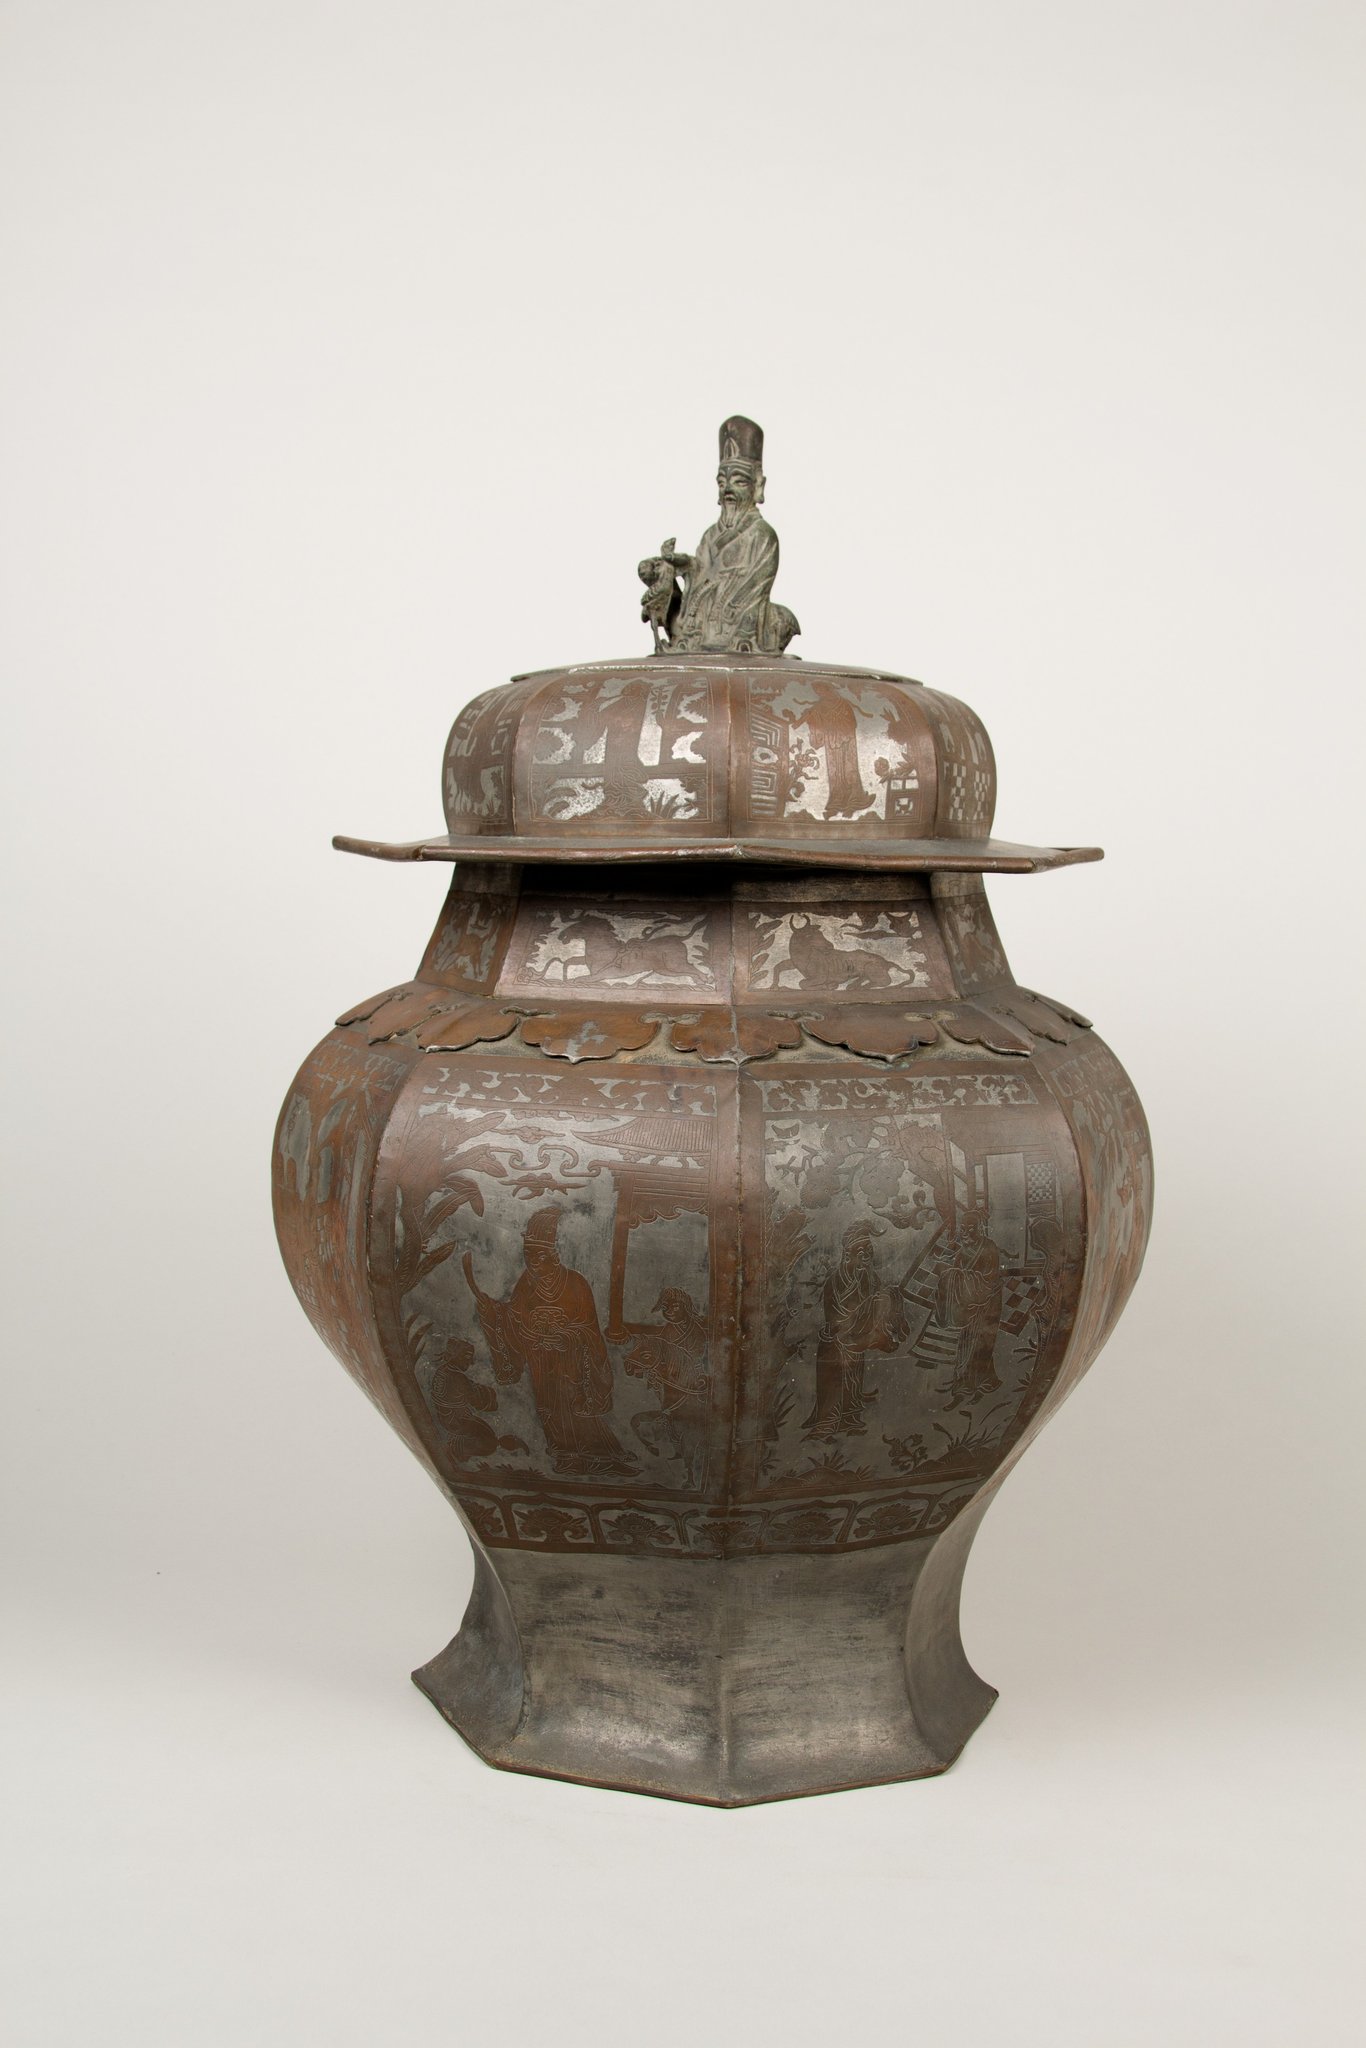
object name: covered jar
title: Octagonal covered jar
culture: chinese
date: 1736-1795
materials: brass, pewter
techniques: inlay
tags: animals,horses